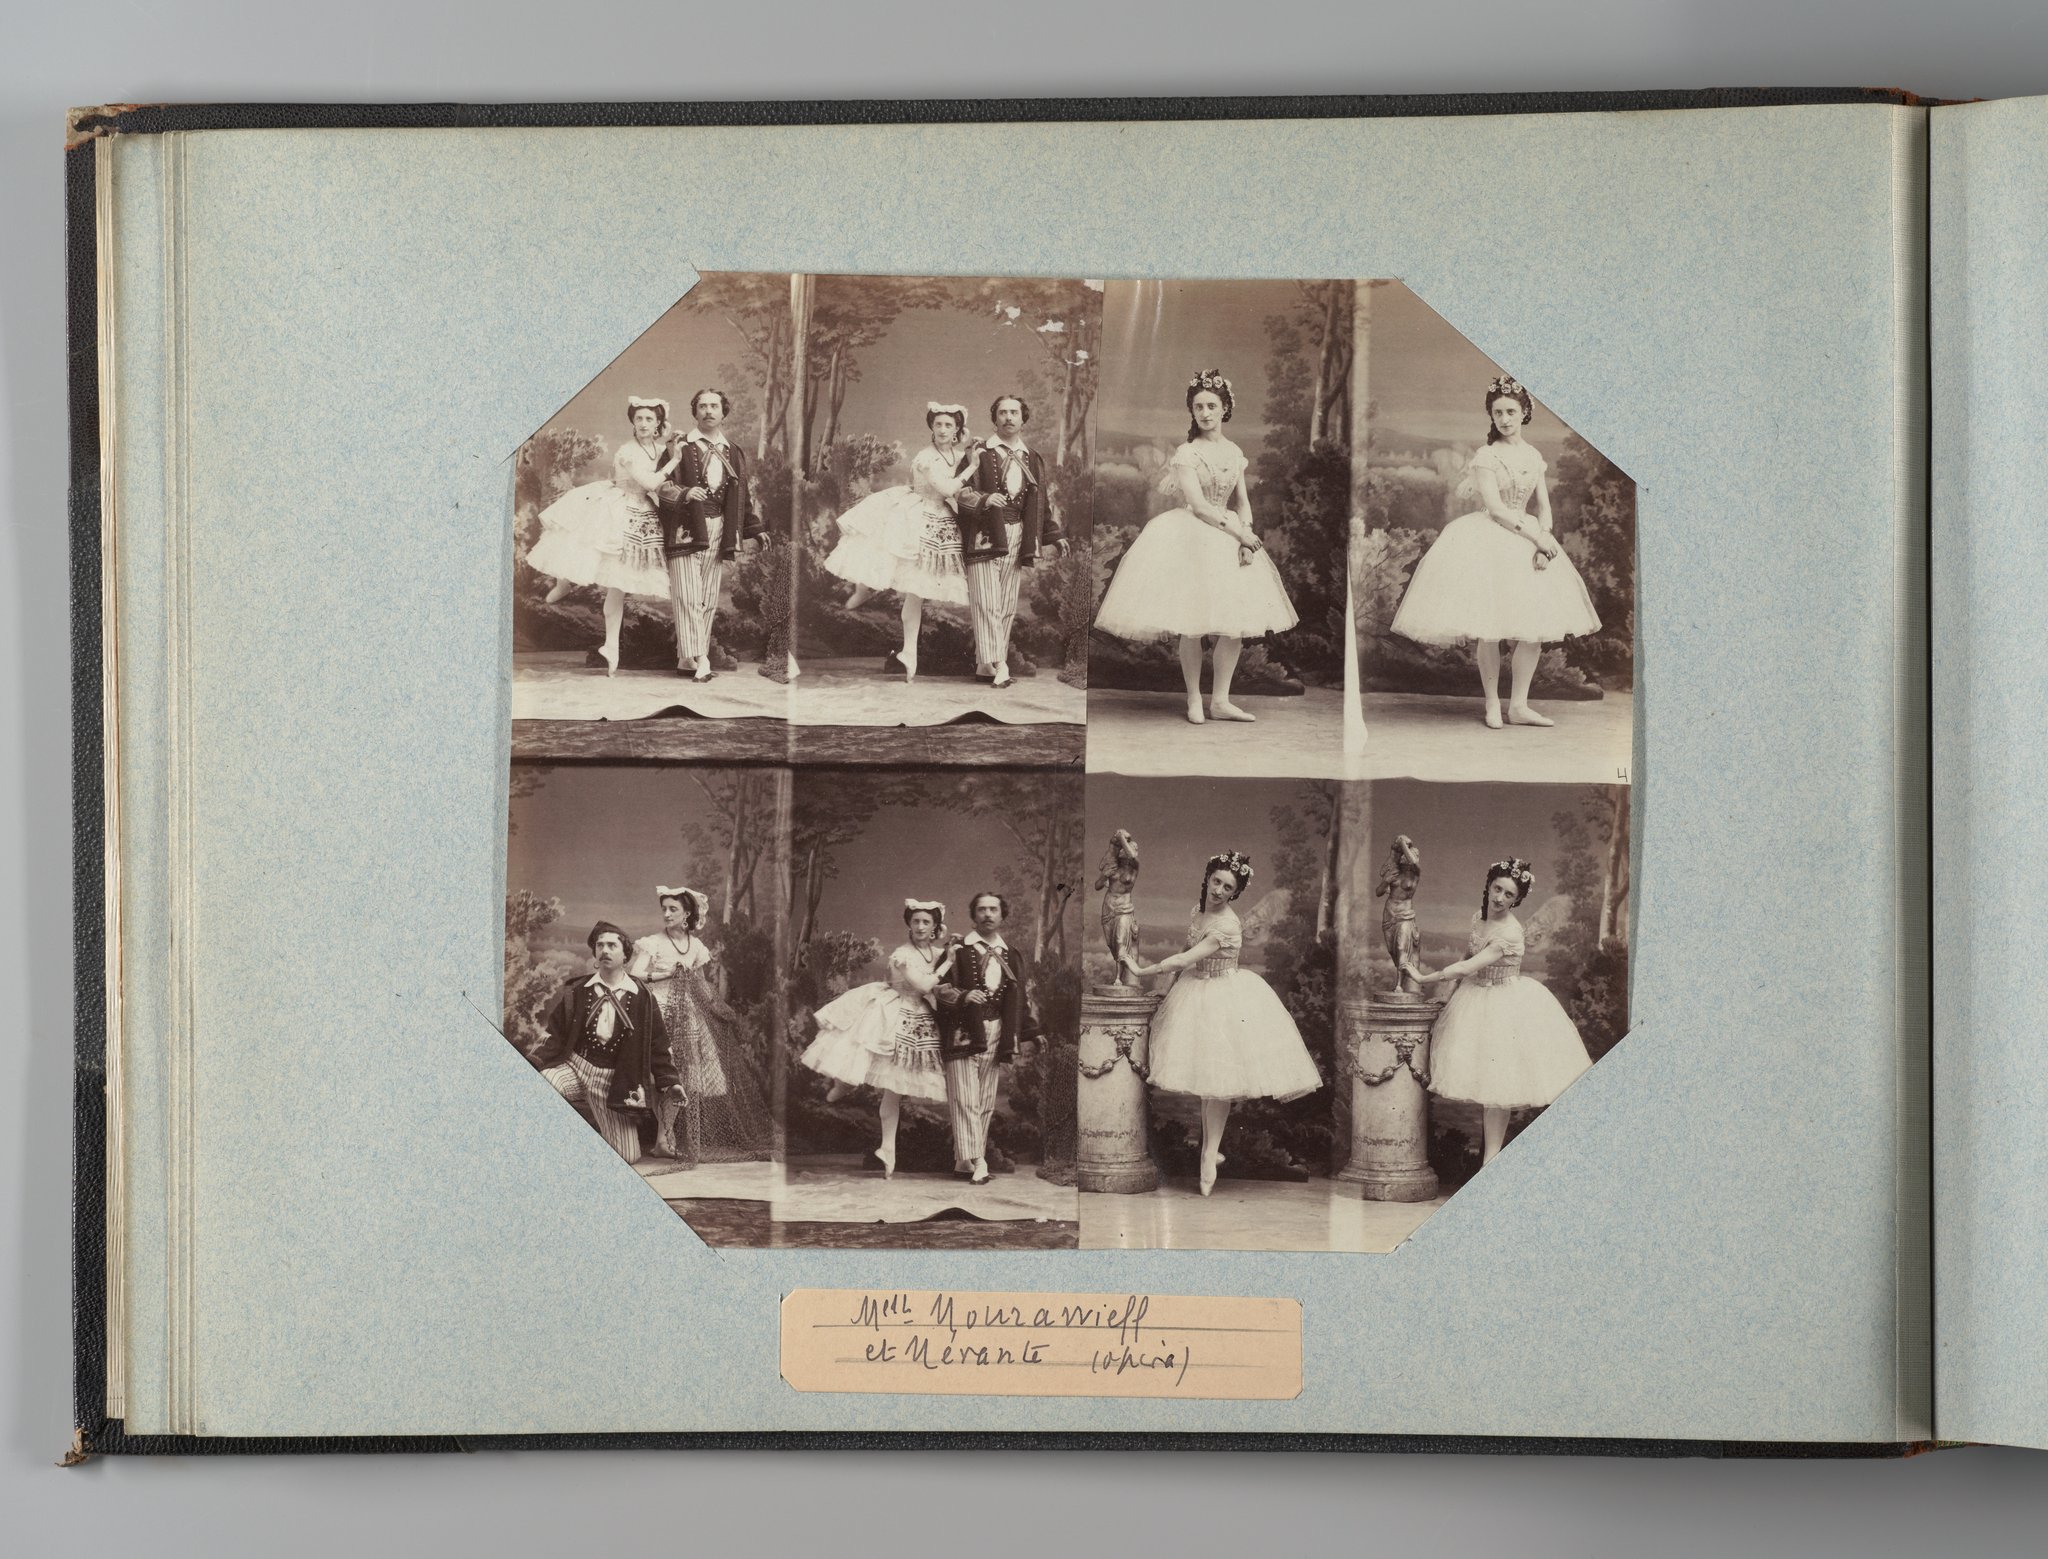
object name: photograph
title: Mlle Mourawieff et Mérante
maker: andré-adolphe-eugène disdéri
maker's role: artist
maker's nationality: french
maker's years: 1819-1889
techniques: albumen silver print, glass negative